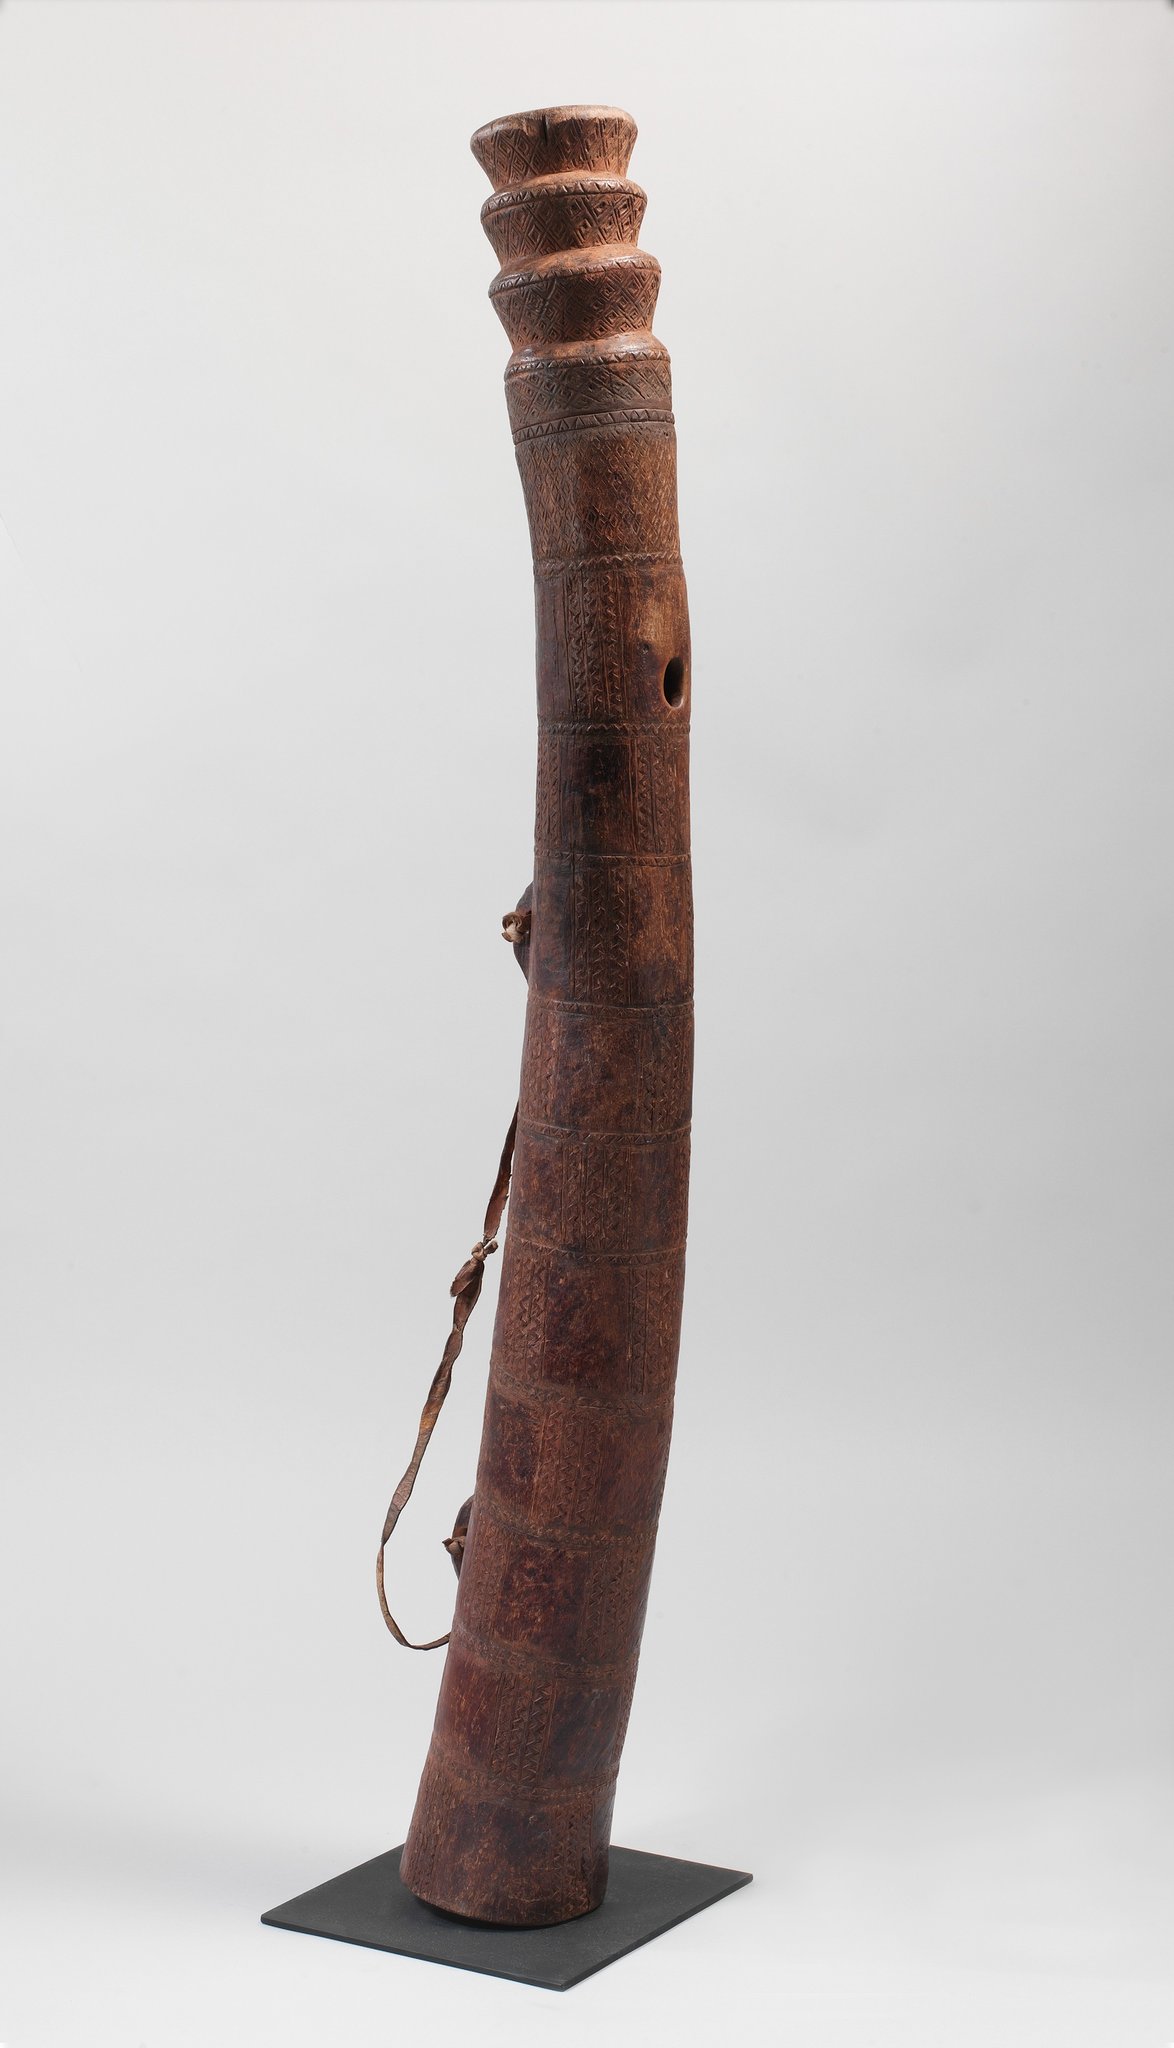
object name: yuge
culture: dinka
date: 1890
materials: leather, wood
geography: sudan